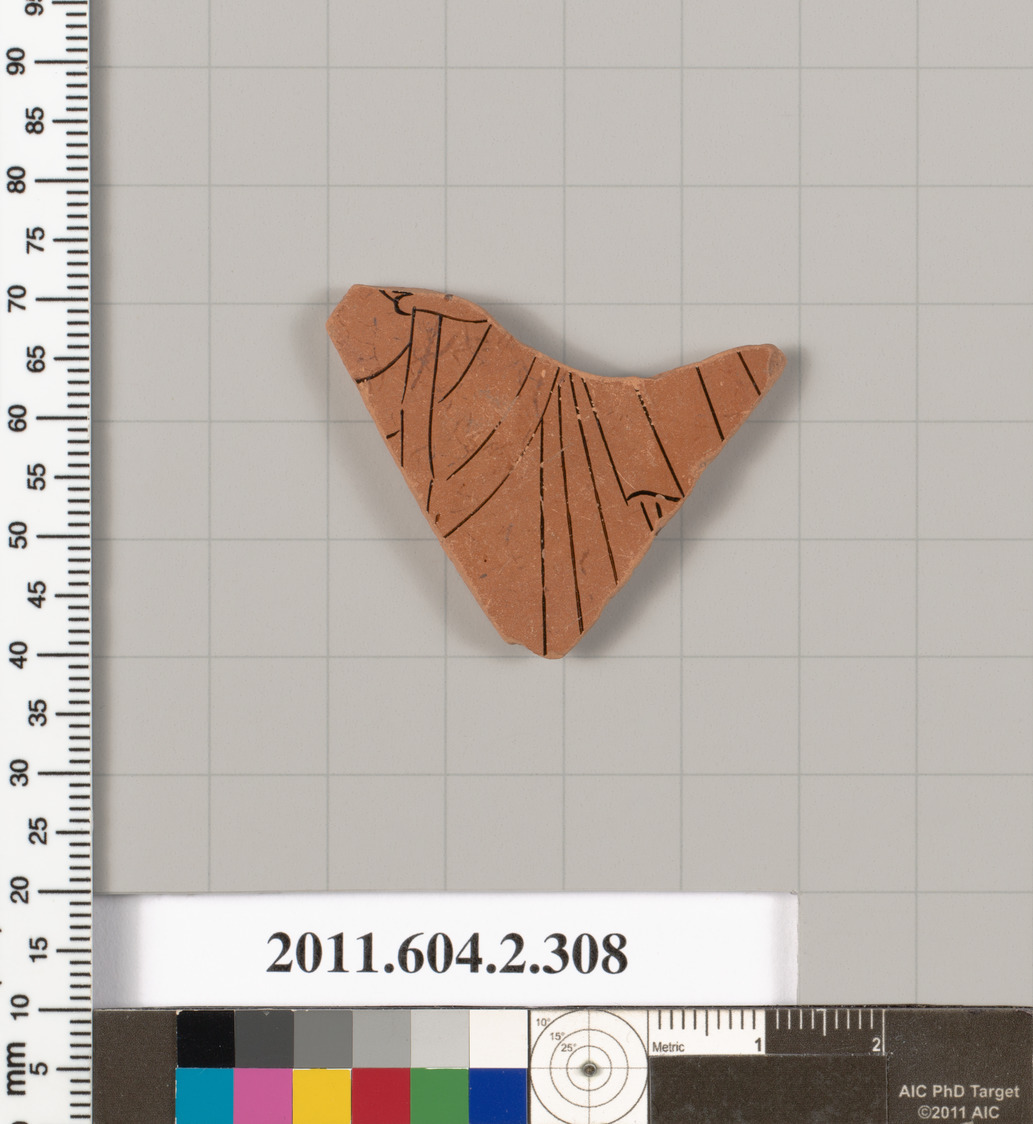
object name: column krater fragment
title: Terracotta fragment of a column-krater (bowl for mixing wine and water)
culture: greek, attic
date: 475-451 BCE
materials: terracotta